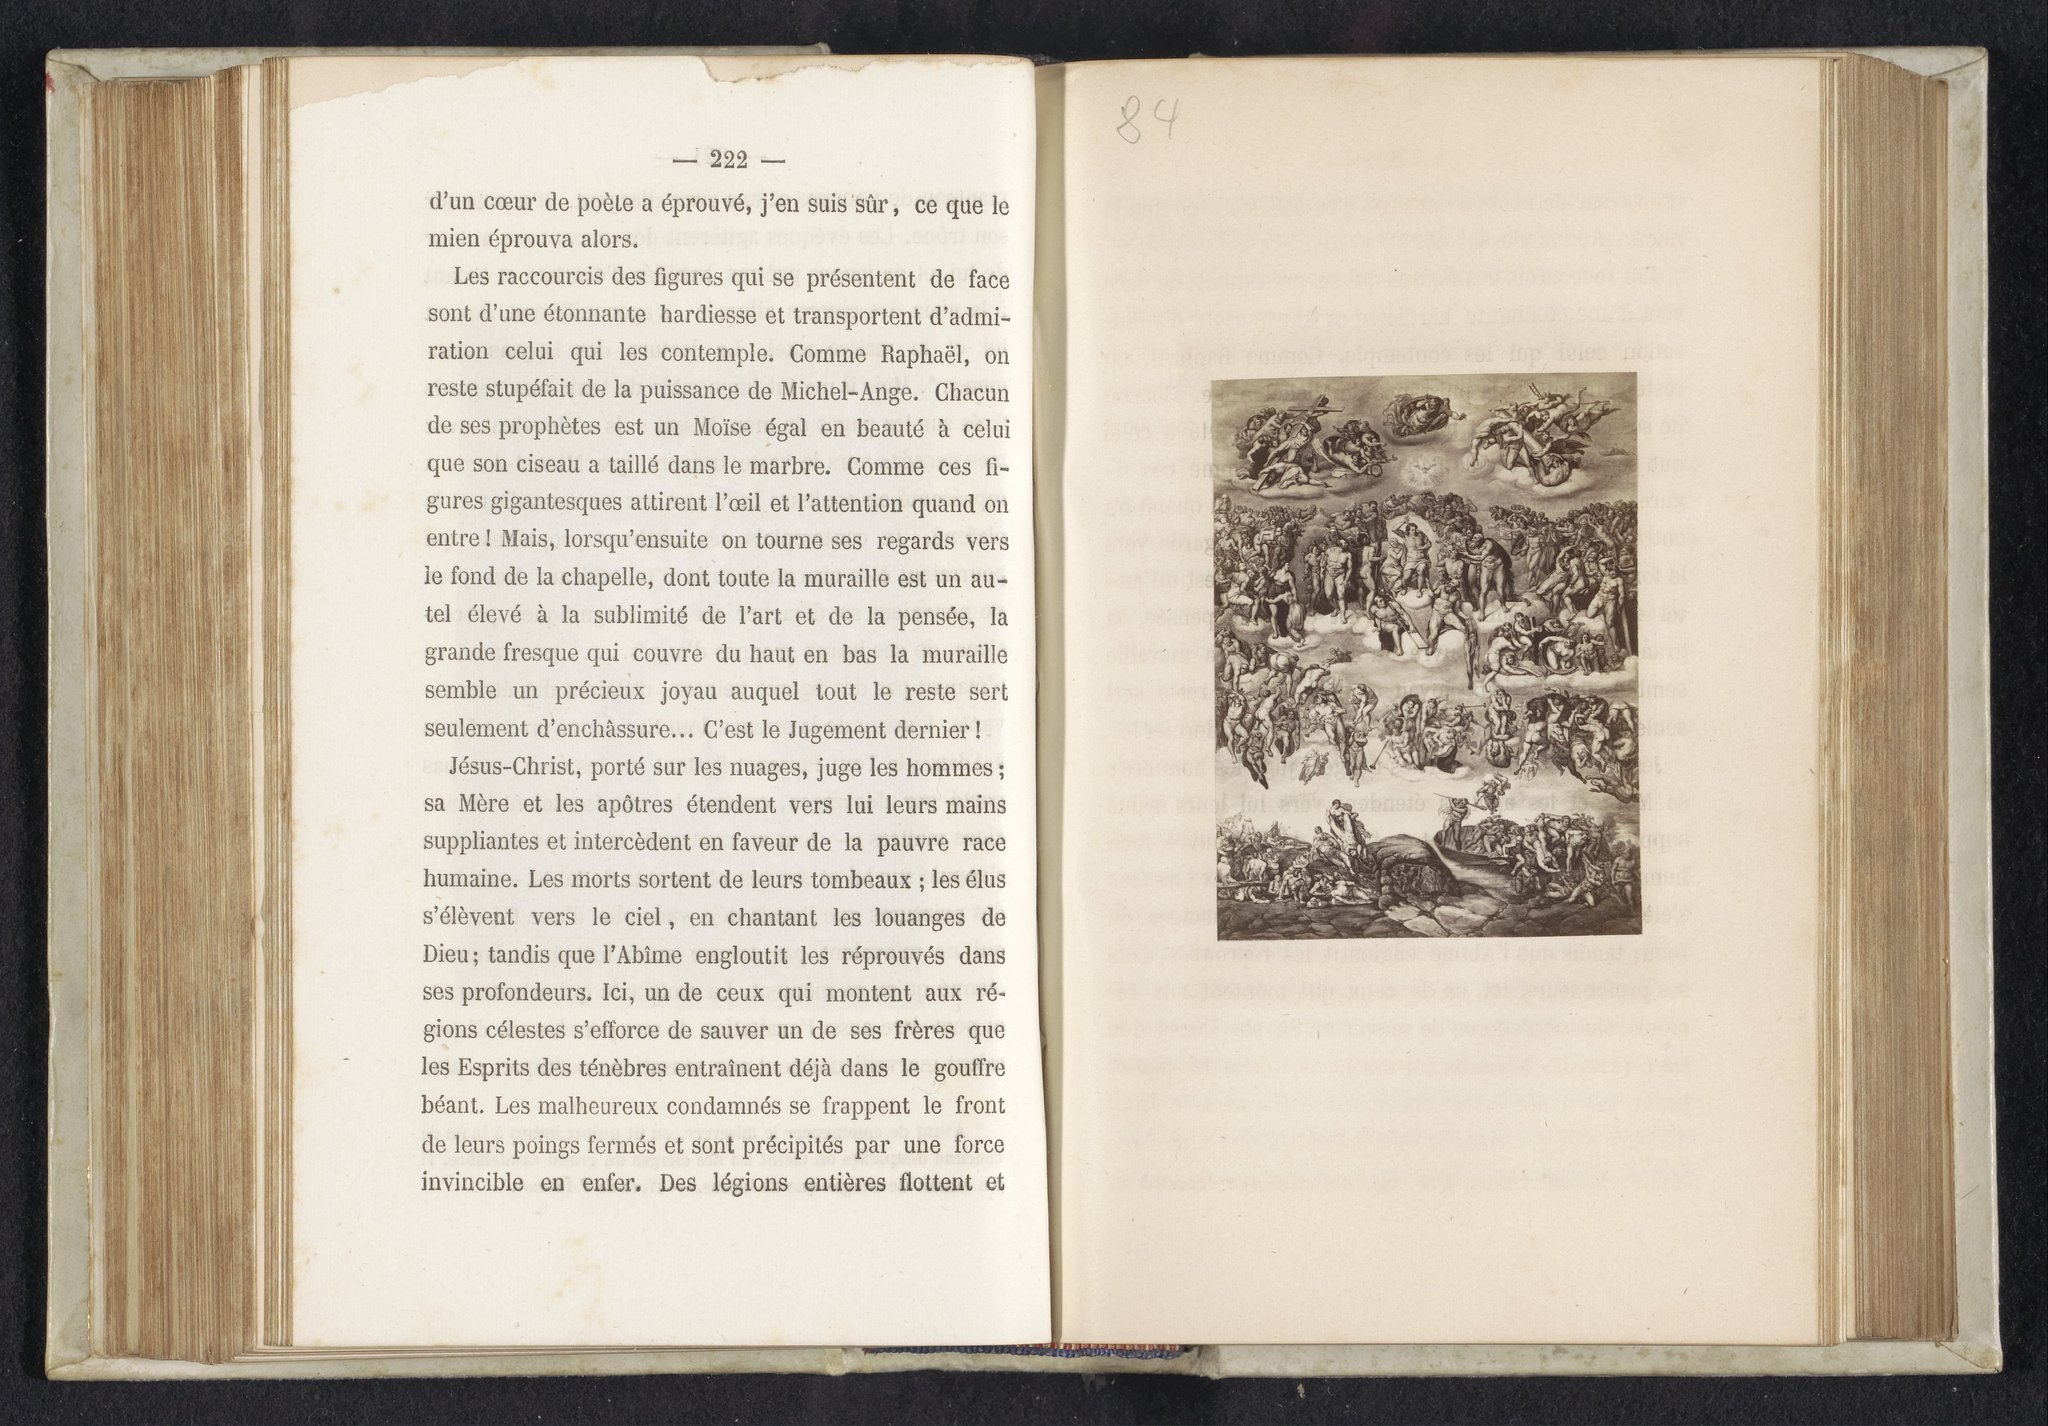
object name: photograph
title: Fotoreproductie van een prent naar een fresco, voorstellende het Laatste Oordeel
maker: Anonymous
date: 1850-1860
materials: photographic support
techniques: albumen print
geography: vatican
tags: last judgement